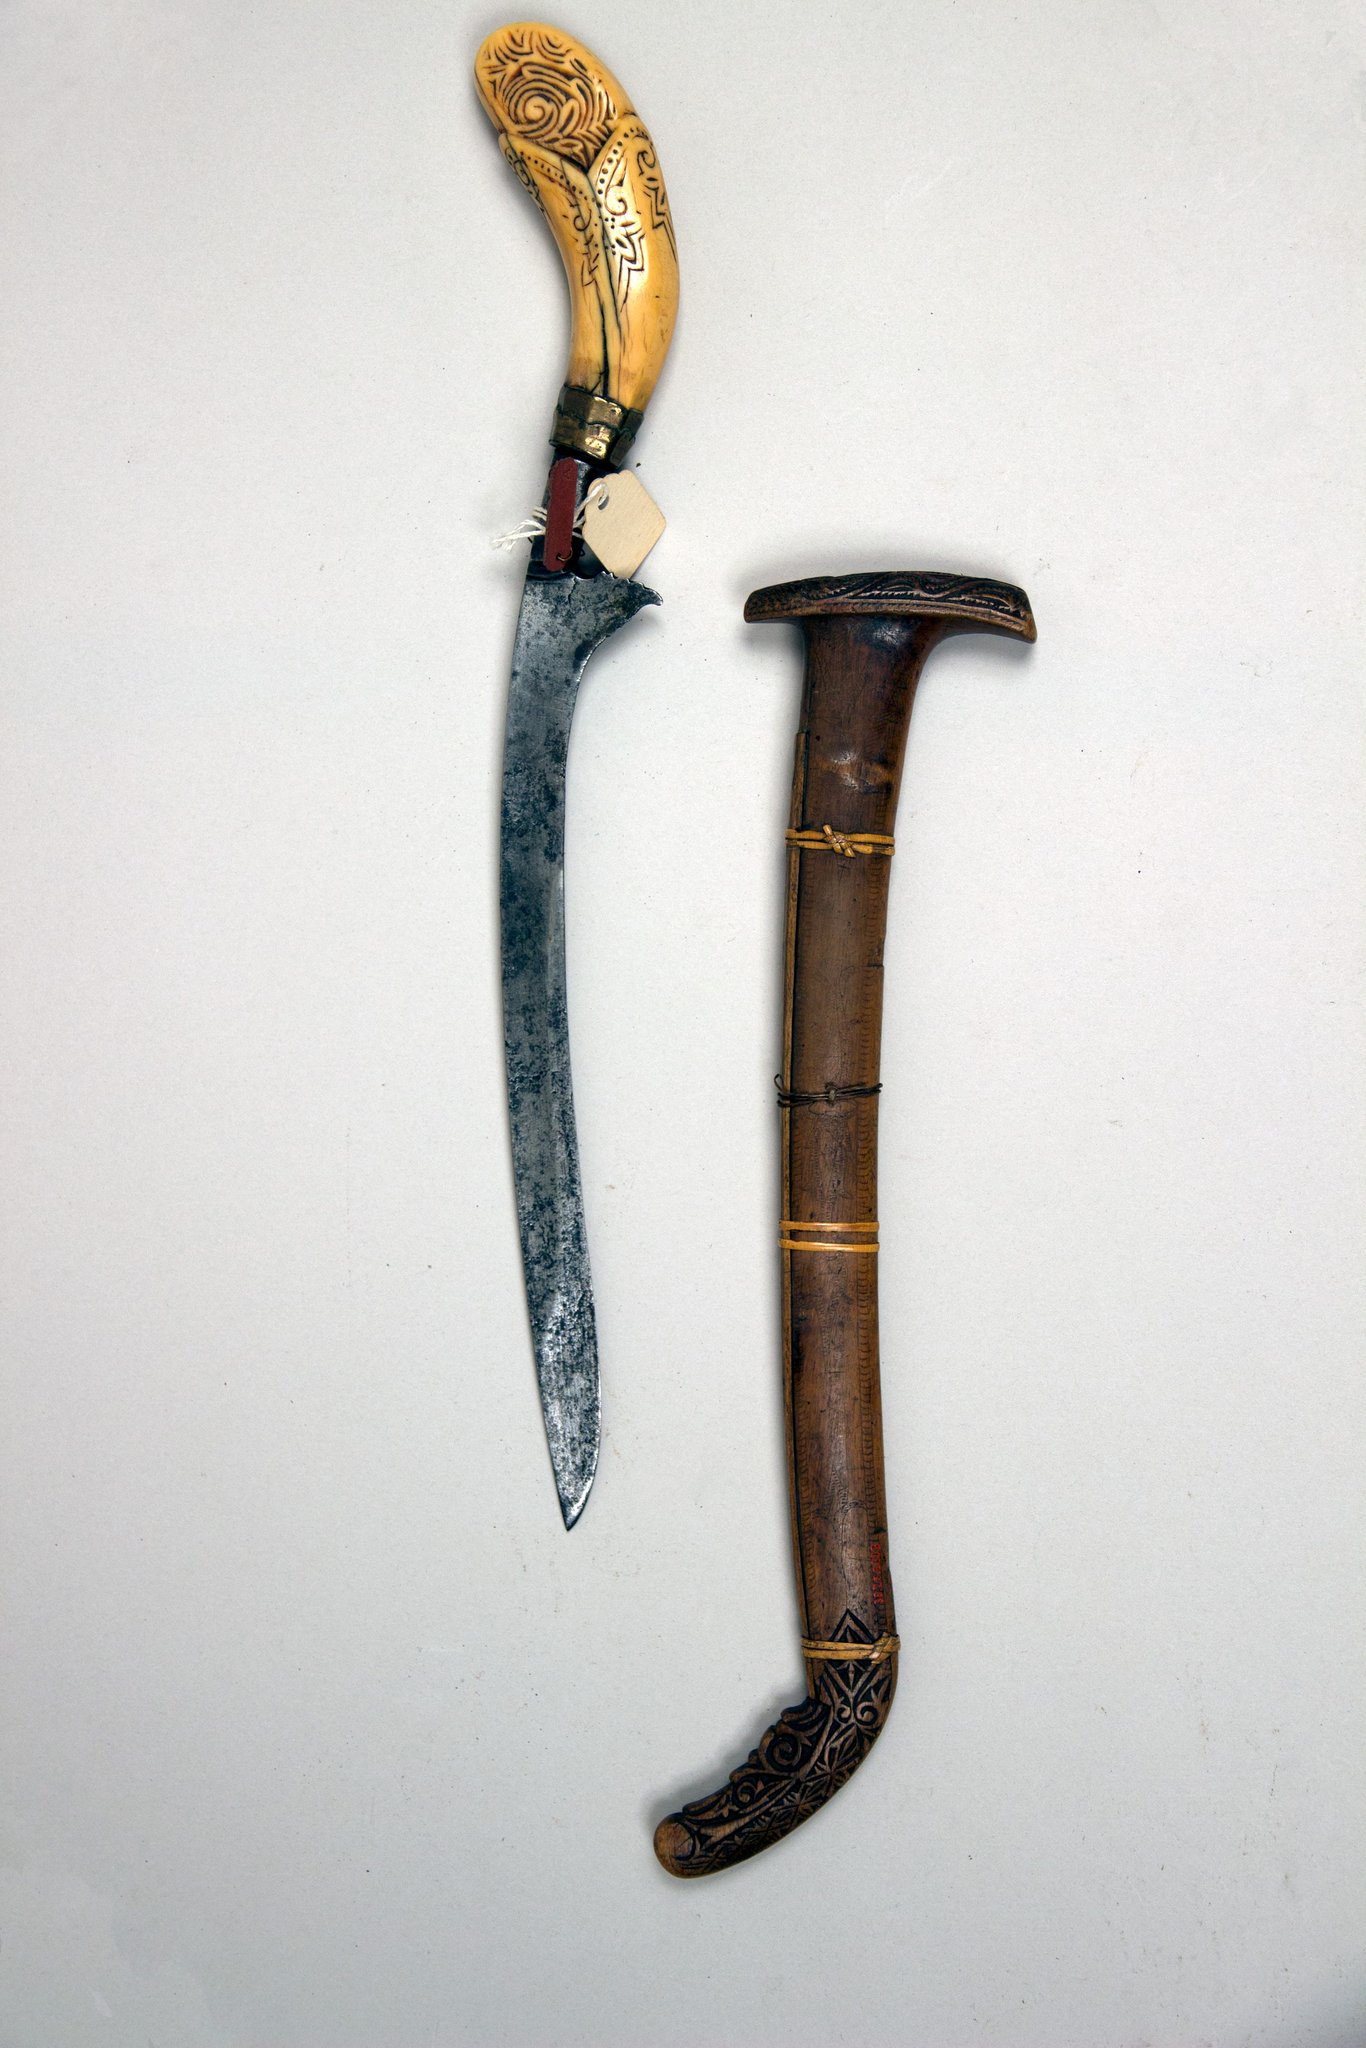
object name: dagger bade bade with sheath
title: Dagger (Bade-bade) with Sheath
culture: sumatran or acheen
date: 1501-1900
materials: bone, steel, wood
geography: indonesia